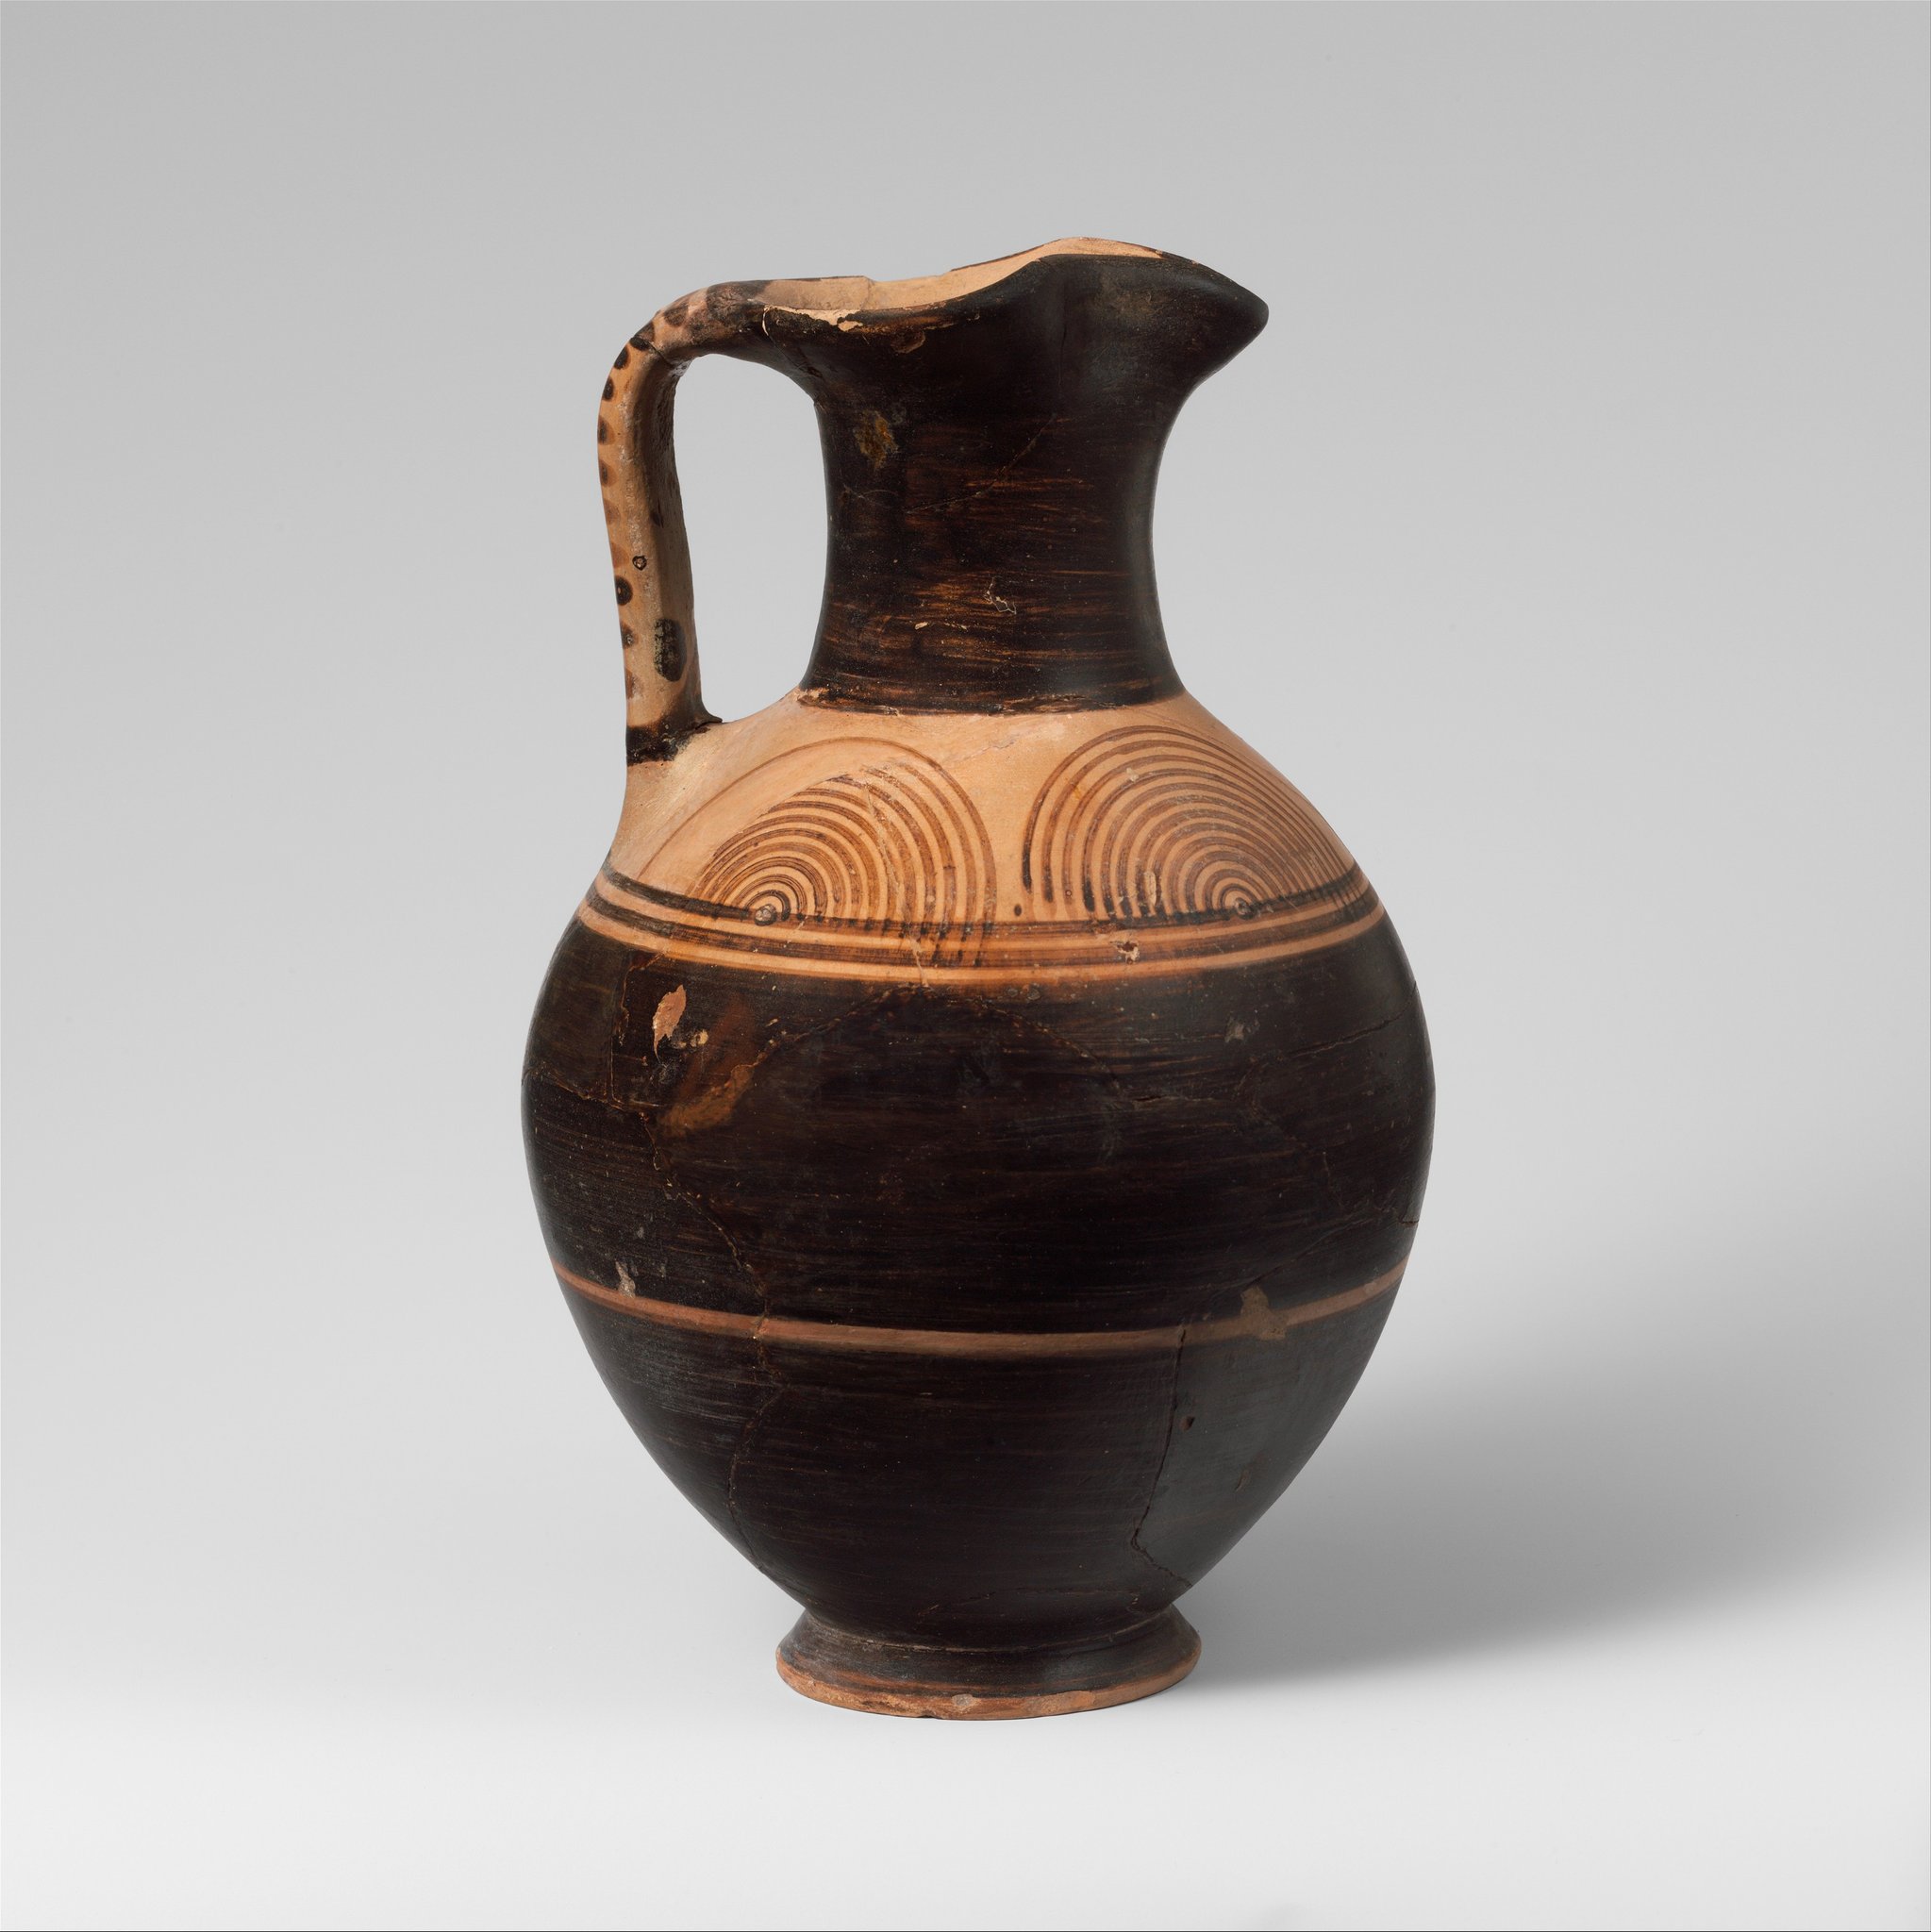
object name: vase fragment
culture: greek, attic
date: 800-701 BCE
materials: terracotta